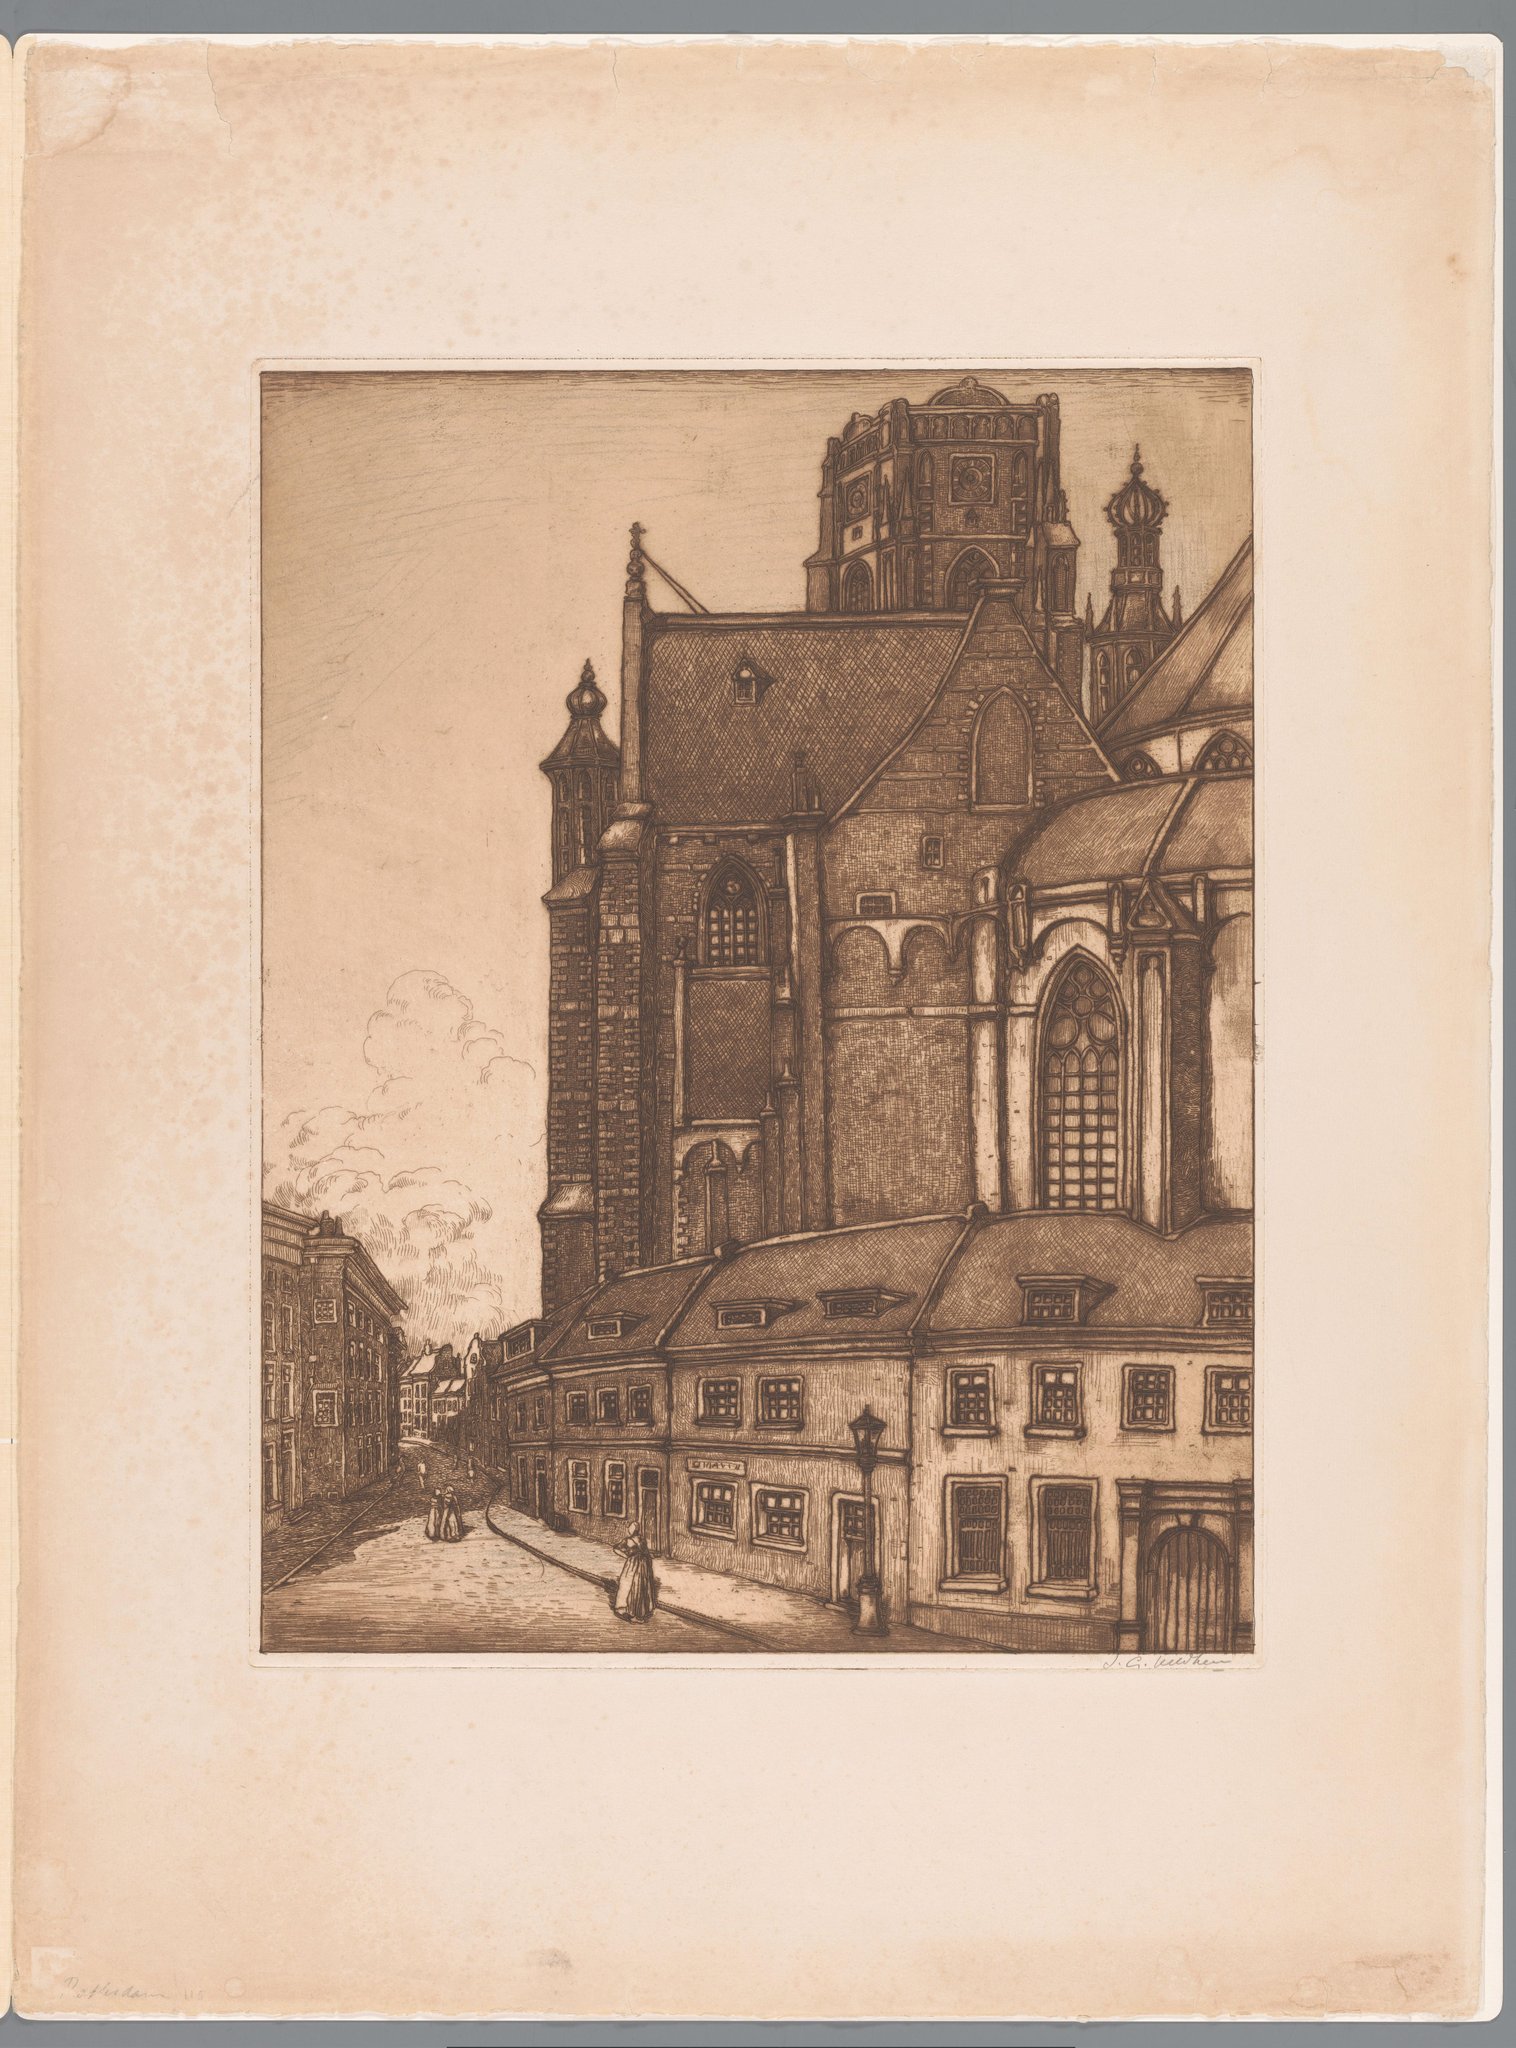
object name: print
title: Gezicht op de St. Laurenskerk te Rotterdam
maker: jacobus gerardus veldheer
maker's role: draughtsman, print maker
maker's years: 1866-1954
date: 1876-1954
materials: paper, pencil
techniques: etching, intaglio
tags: church (exterior)